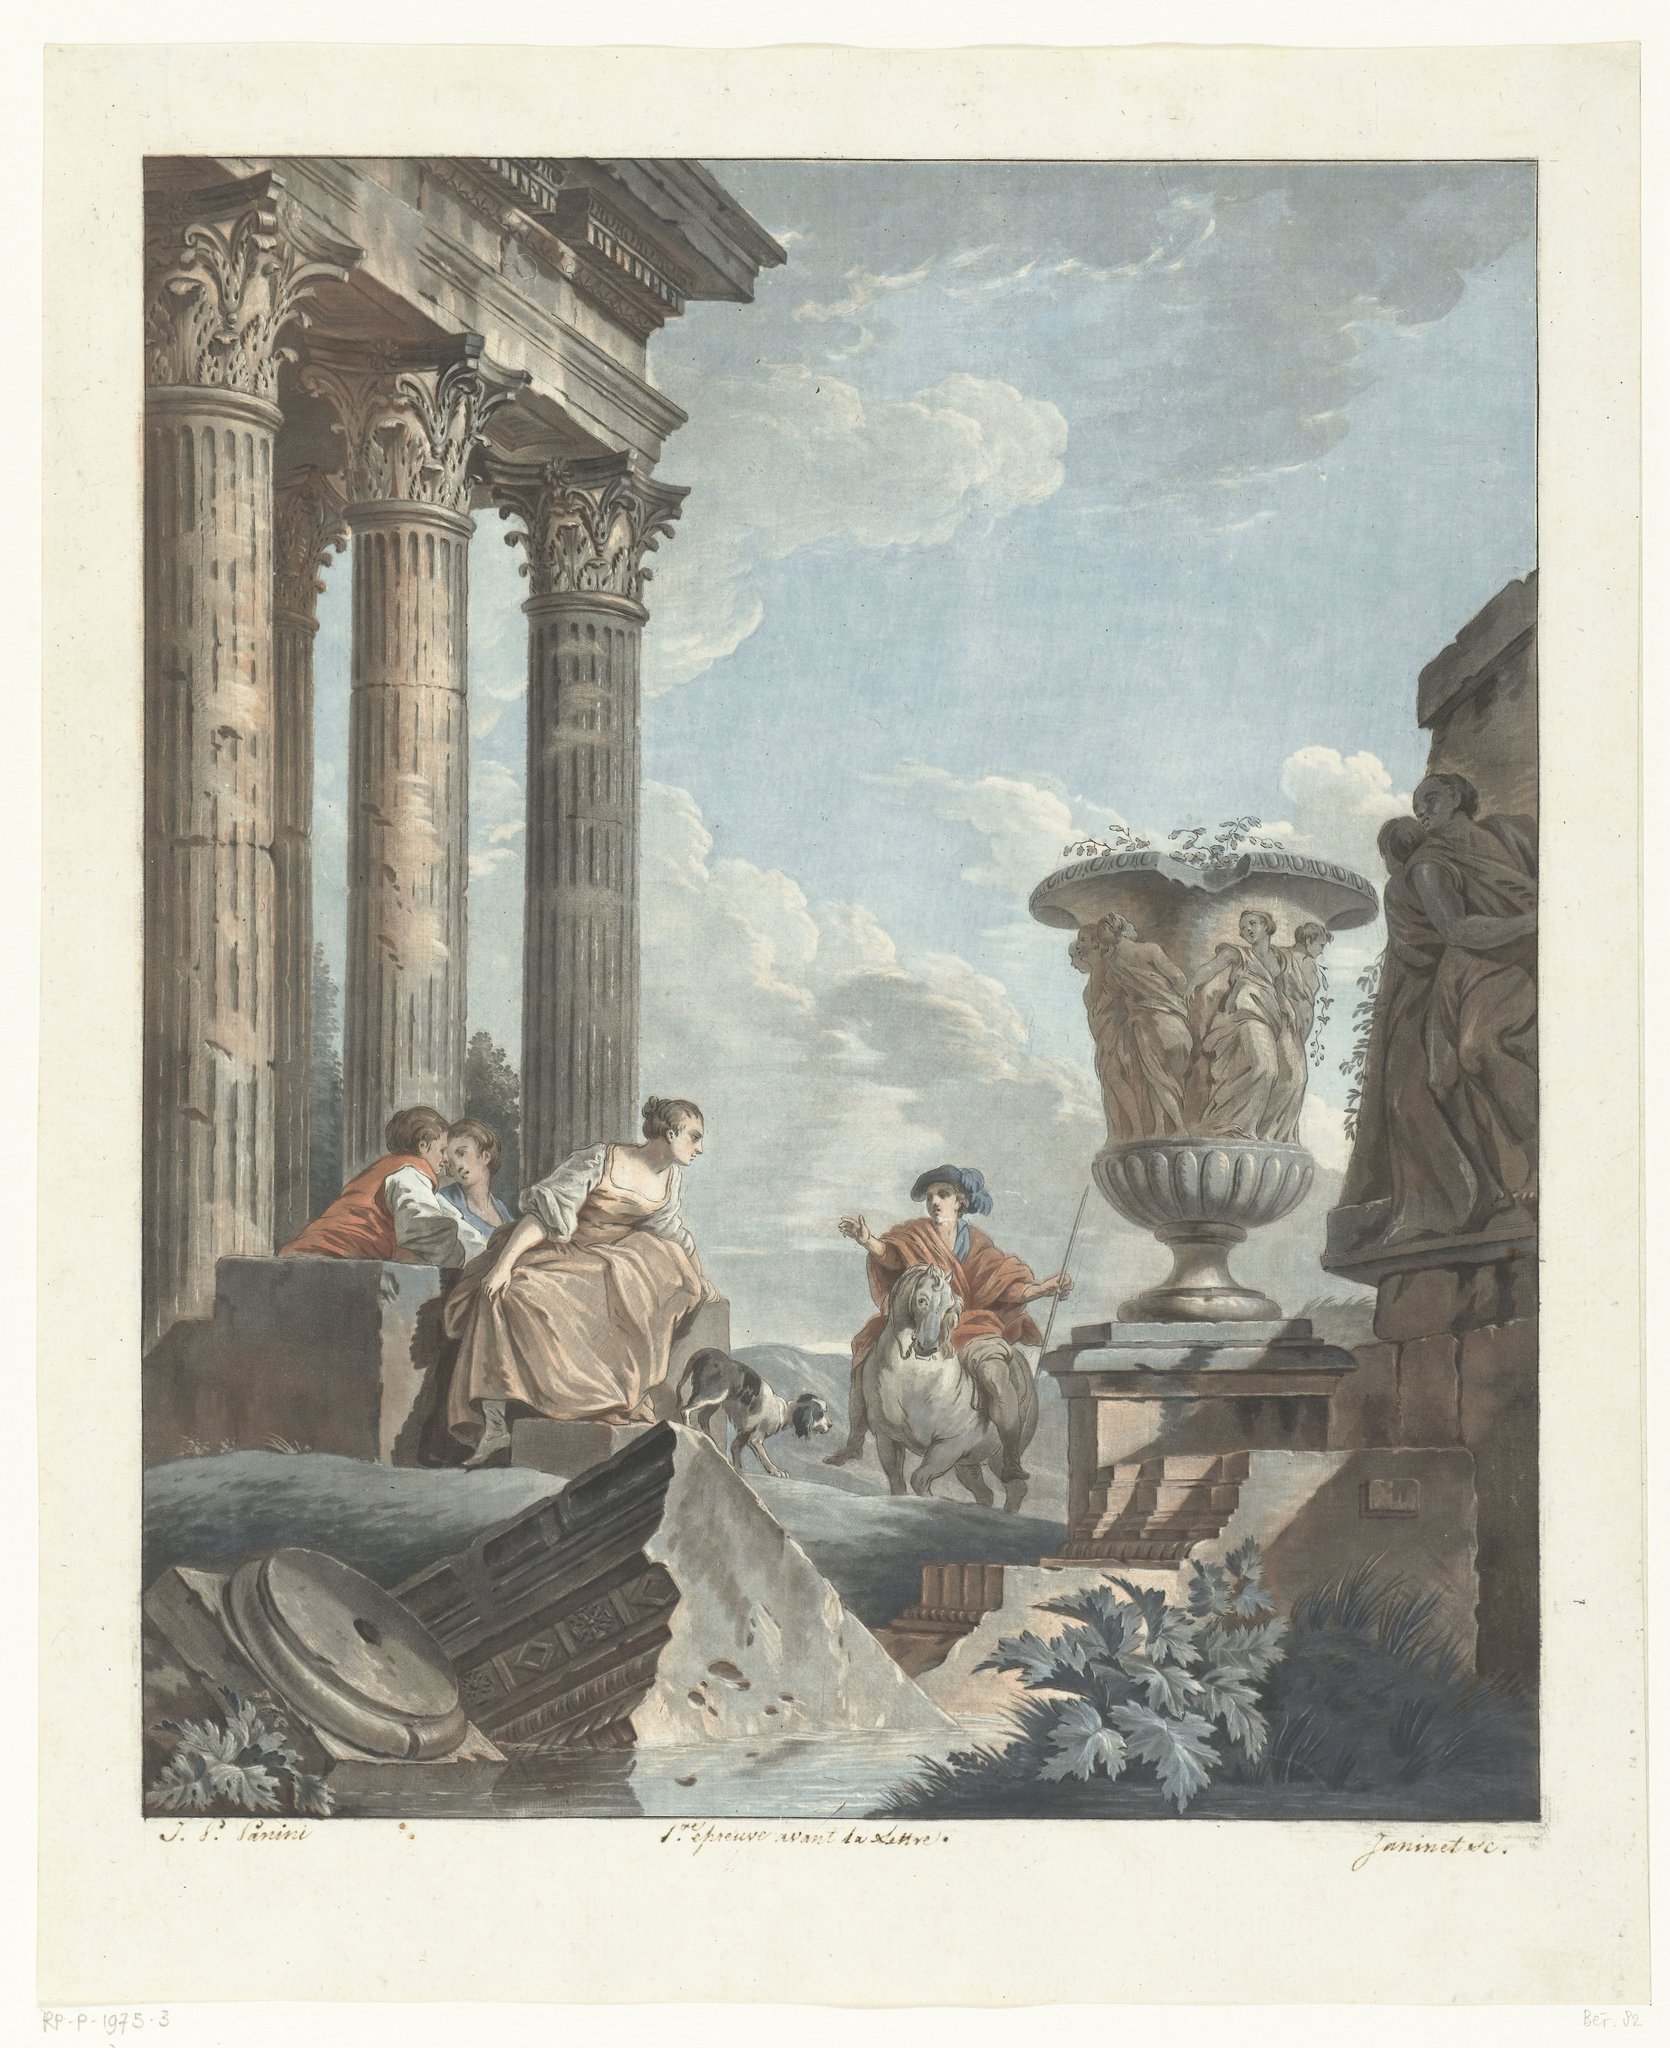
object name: print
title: Antieke ruïnes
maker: jean françois janinet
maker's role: print maker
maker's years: 1752-1814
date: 1762-1798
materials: paper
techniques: color aquatint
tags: ruin of a building ~ architecture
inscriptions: collector's mark: Lugt 2760, inscription: ‘J.P. Panini 1re epreuve avant la Lettre Janinet sc.’, collector's mark: Lugt 2228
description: Tussen een ruïne van een oude tempel en een antieke vaas vier figuren waarvan één te paard.